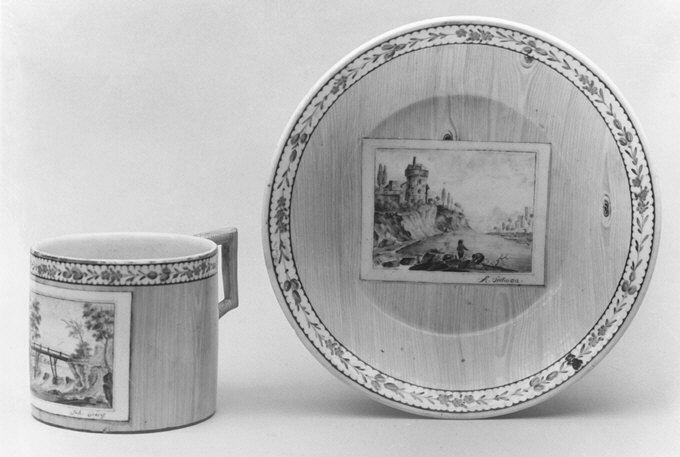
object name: cup and saucer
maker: nymphenburg porcelain manufactory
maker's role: manufactory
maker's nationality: german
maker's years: 1747-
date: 1780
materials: hard paste porcelain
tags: buildings,bridges